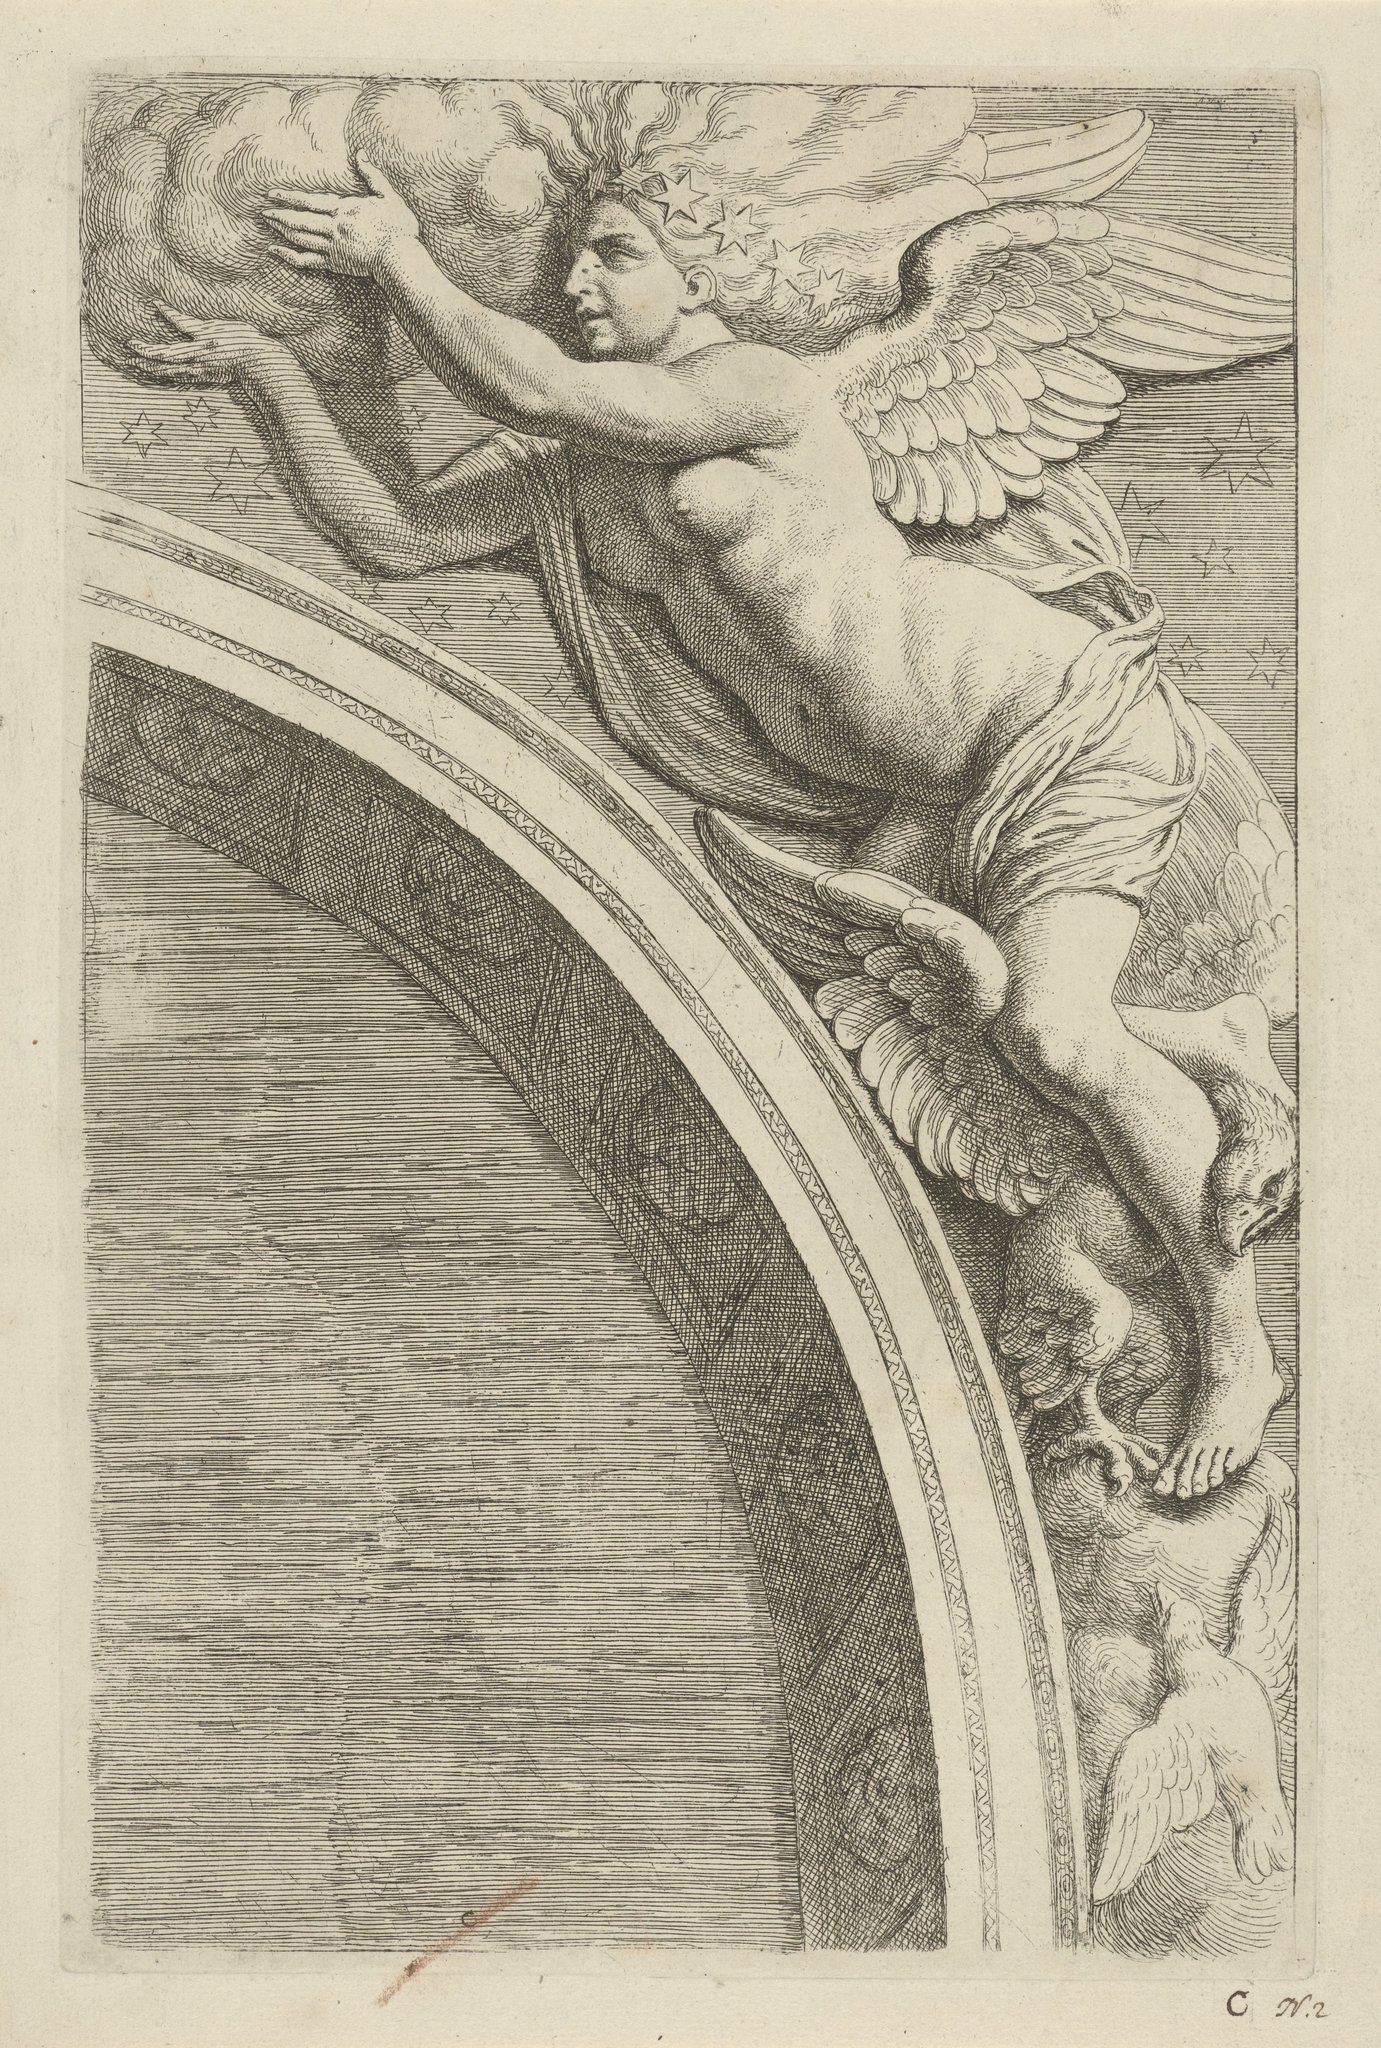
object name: book illustration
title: Reliëf met personificatie van het element Lucht boven boog in de Burgerzaal van het Stadhuis op de Dam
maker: hubert quellinus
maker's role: print maker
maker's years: 1619-1687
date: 1663-1668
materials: chalk, ink, paper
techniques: engraving, etching, pen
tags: predatory birds: eagle, clouds, air (one of the four elements), birds, stars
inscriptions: inscription: ‘C N. 2’, collector's mark: Lugt 2228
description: Huidige staat van prent ook gebruikt in: Secunca pars Praecipuarum effigierum ac ornamentorum amplissime Curiae Amstelrodamensis maiori ex parte in cadido marmore effectorum per Artum Quellinium eiusdem Civitatis Statuarium / Het tweede deel Van de voornaemste Statuen ende Cieraten van 't konst-rijcke Stadt-huys van Amstelredam 'tmeeste in Marmer gemaeckt door Artus Quellinus Beelthouwer der voorseyde Stadt. Amsterdam: Artus Quellinus (I), 1663. En in: Secunca pars Praecipuarum effigierum ac ornamentorum amplissime Curiae Amstelrodamensis maiori ex parte in cadido marmore effectorum per Artum Quellinium eiusdem Civitatis Statuarium / Het tweede deel Van de voornaemste Statuen ende Cieraten van 't konst-rijcke Stadt-huys van Amstelredam 'tmeeste in Marmer gemaeckt door Artus Quellinus Beelthouwer der voorseyde Stadt. Amsterdam: Frederik de Wit, 1668. Latere staat van prent ook gebruikt in: Architecture peinture et sculpture de la Maison de Ville d'Amsterdam, representee en CIX. figures en taille-douce (…). Amsterdam: David Mortier, 1719. En in: Architecture peinture et sculpture de la Maison de Ville d'Amsterdam, representee en CIX. figures en taille-douce (…). Amsterdam: Gerard Valck, 1719. En in: Bouw schilder en beeldhouwkonst, van het Stadhuis te Amsteldam, vertoont in CIX figuuren (…). Amsterdam: Covens & Mortier & Covens Jr., s.a. (1774-1783).